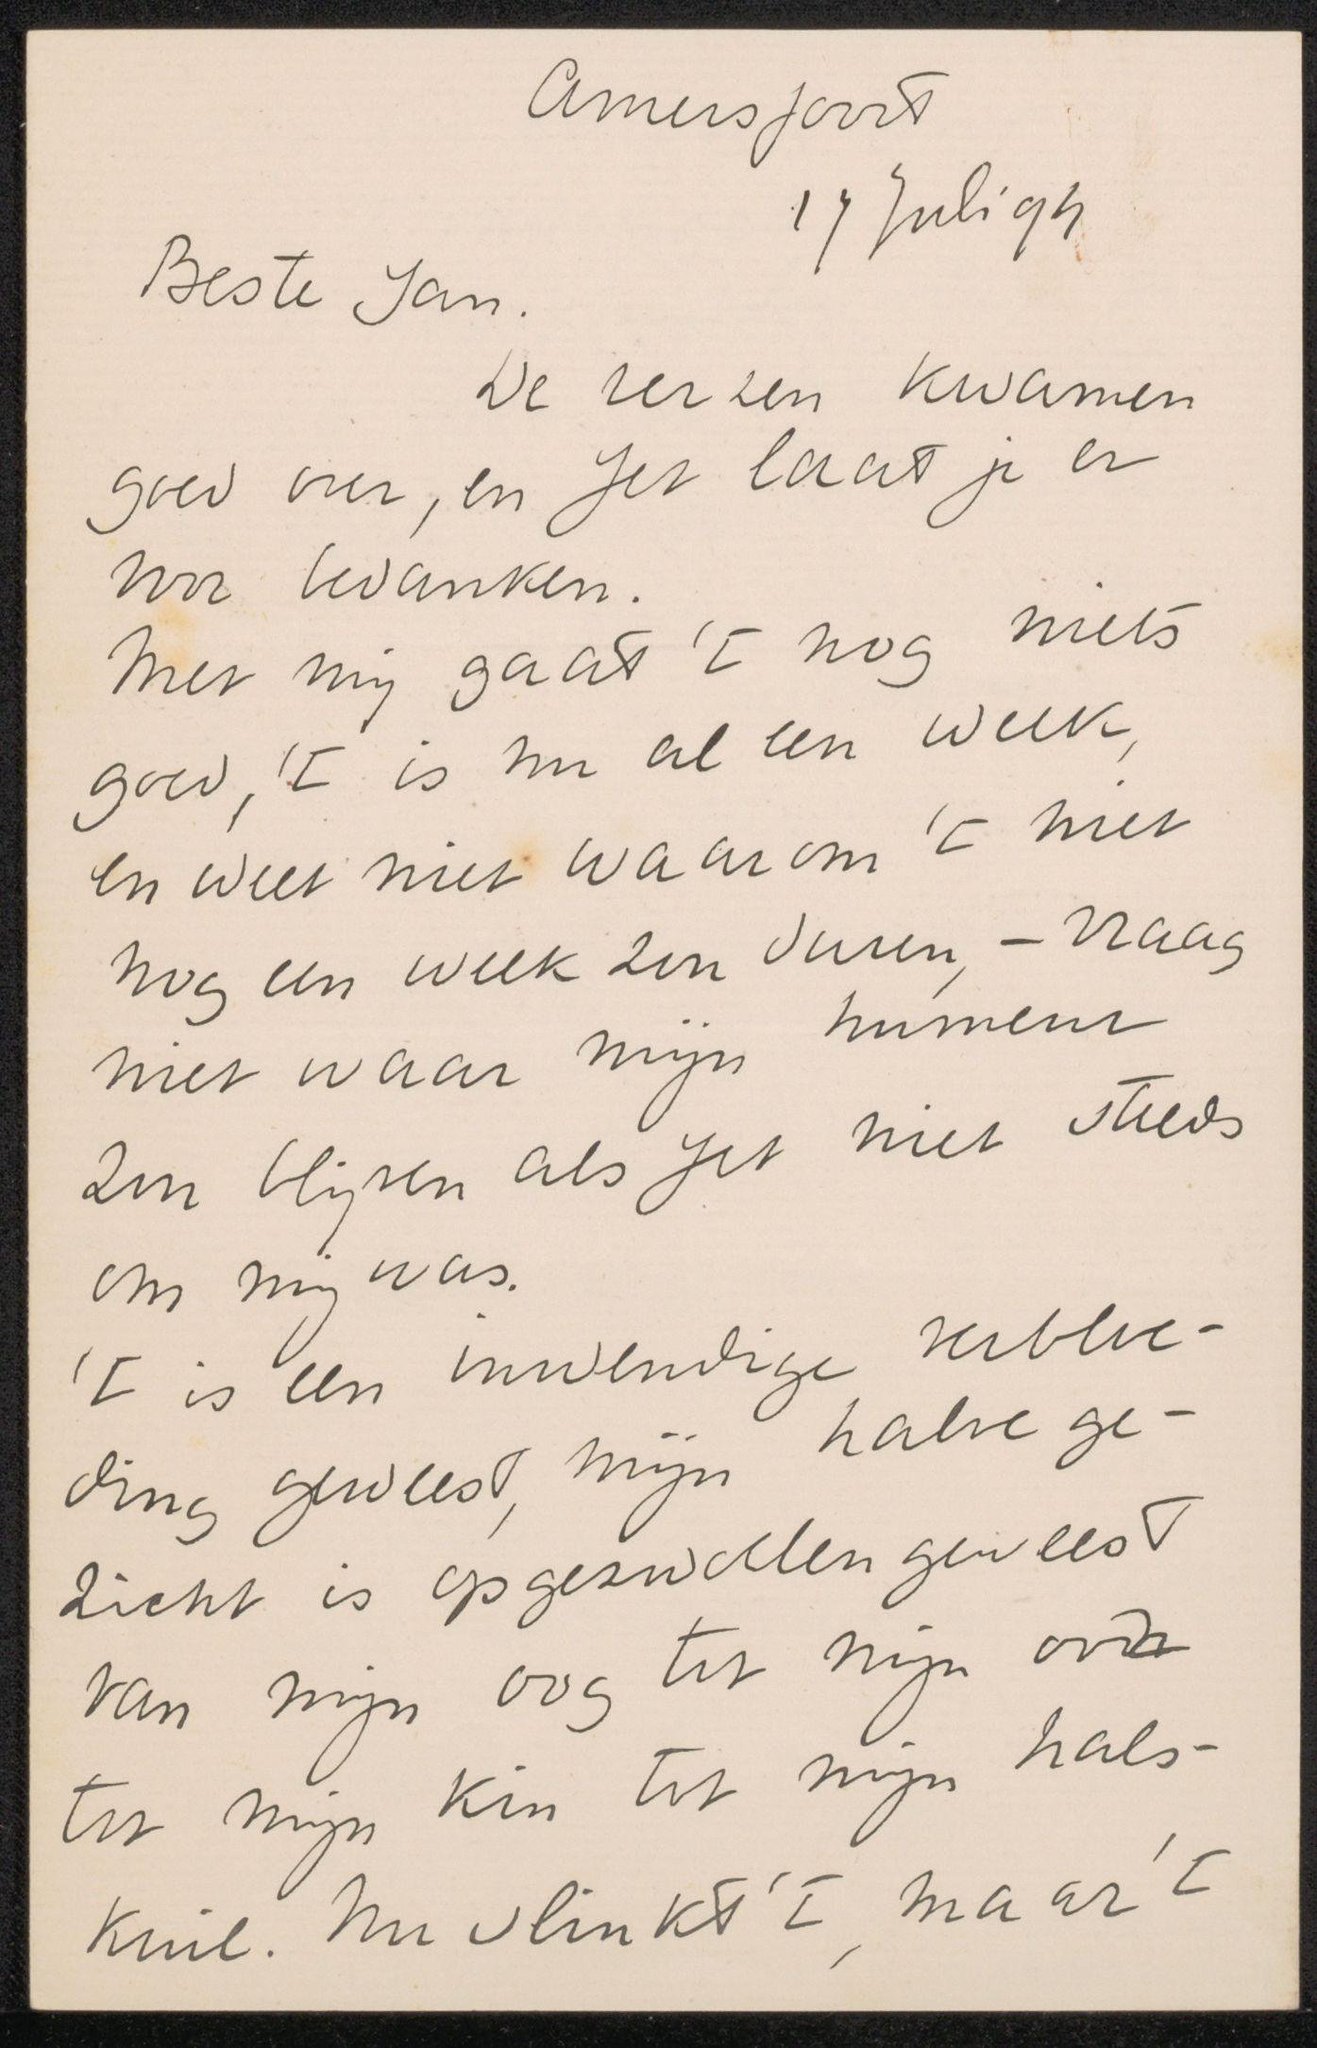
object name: letter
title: Brief aan Jan Veth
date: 1879-1925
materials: ink, paper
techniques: pen, writing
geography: amersfoort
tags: painter, print maker, draughtsman, jan veth, willem kloos, utrecht, literature ~ arts, diseases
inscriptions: collector's mark: ‘RPK’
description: Brief gedateerd 17 Juli 94 in latere hand.